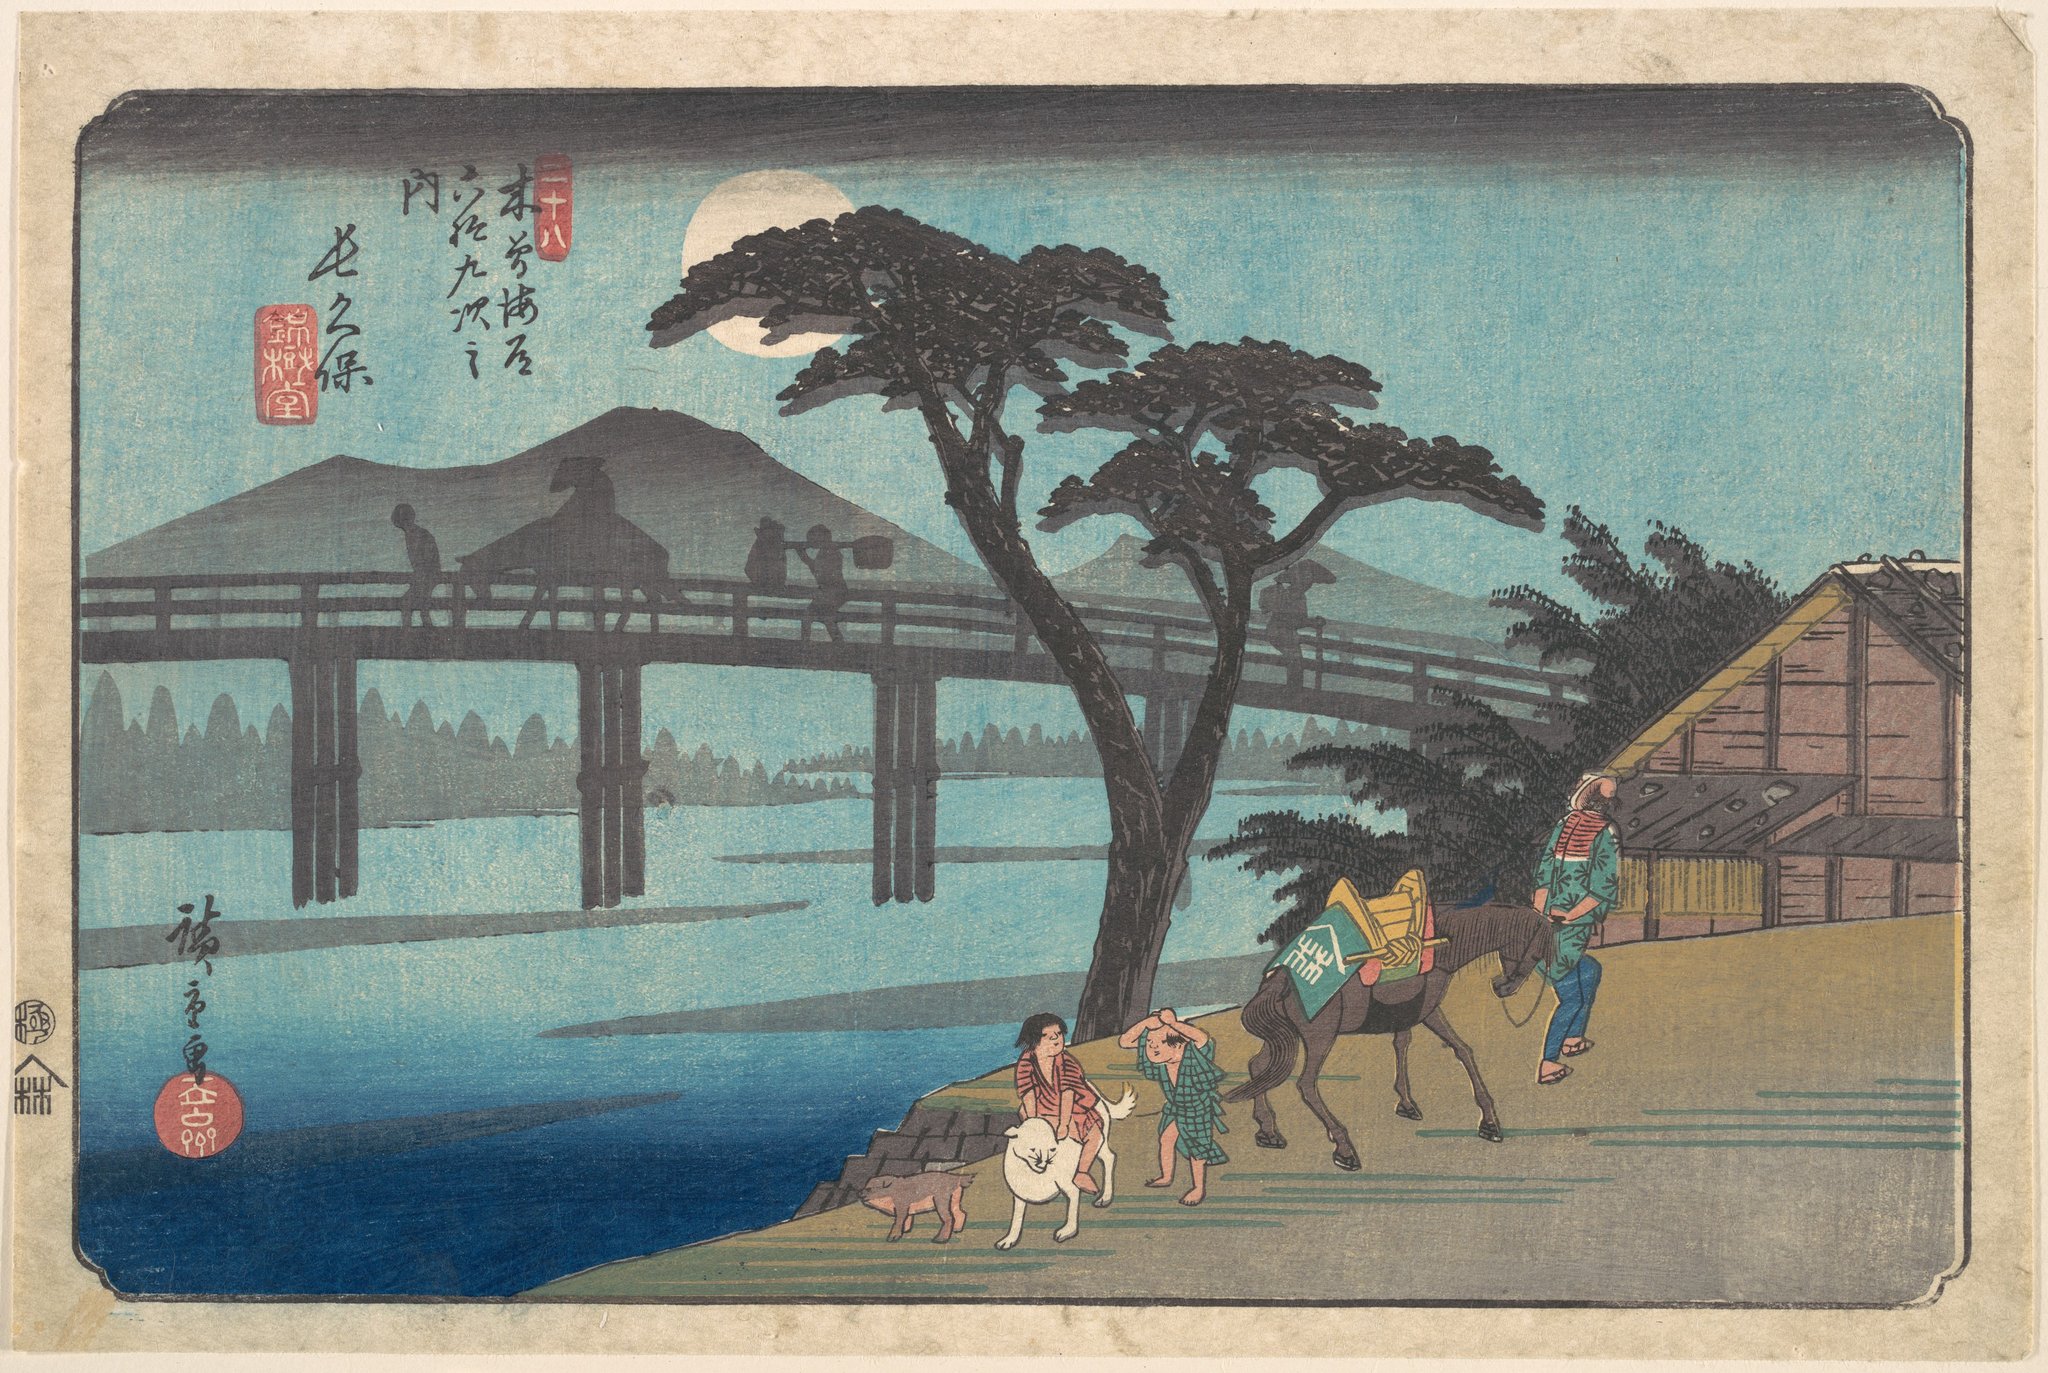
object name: print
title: Nagakubo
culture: japanese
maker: utagawa hiroshige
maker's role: artist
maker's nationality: japanese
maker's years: 1797-1858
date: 1797-1858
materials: ink, paper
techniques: woodblock print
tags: houses,bridges,horses,mountains,trees